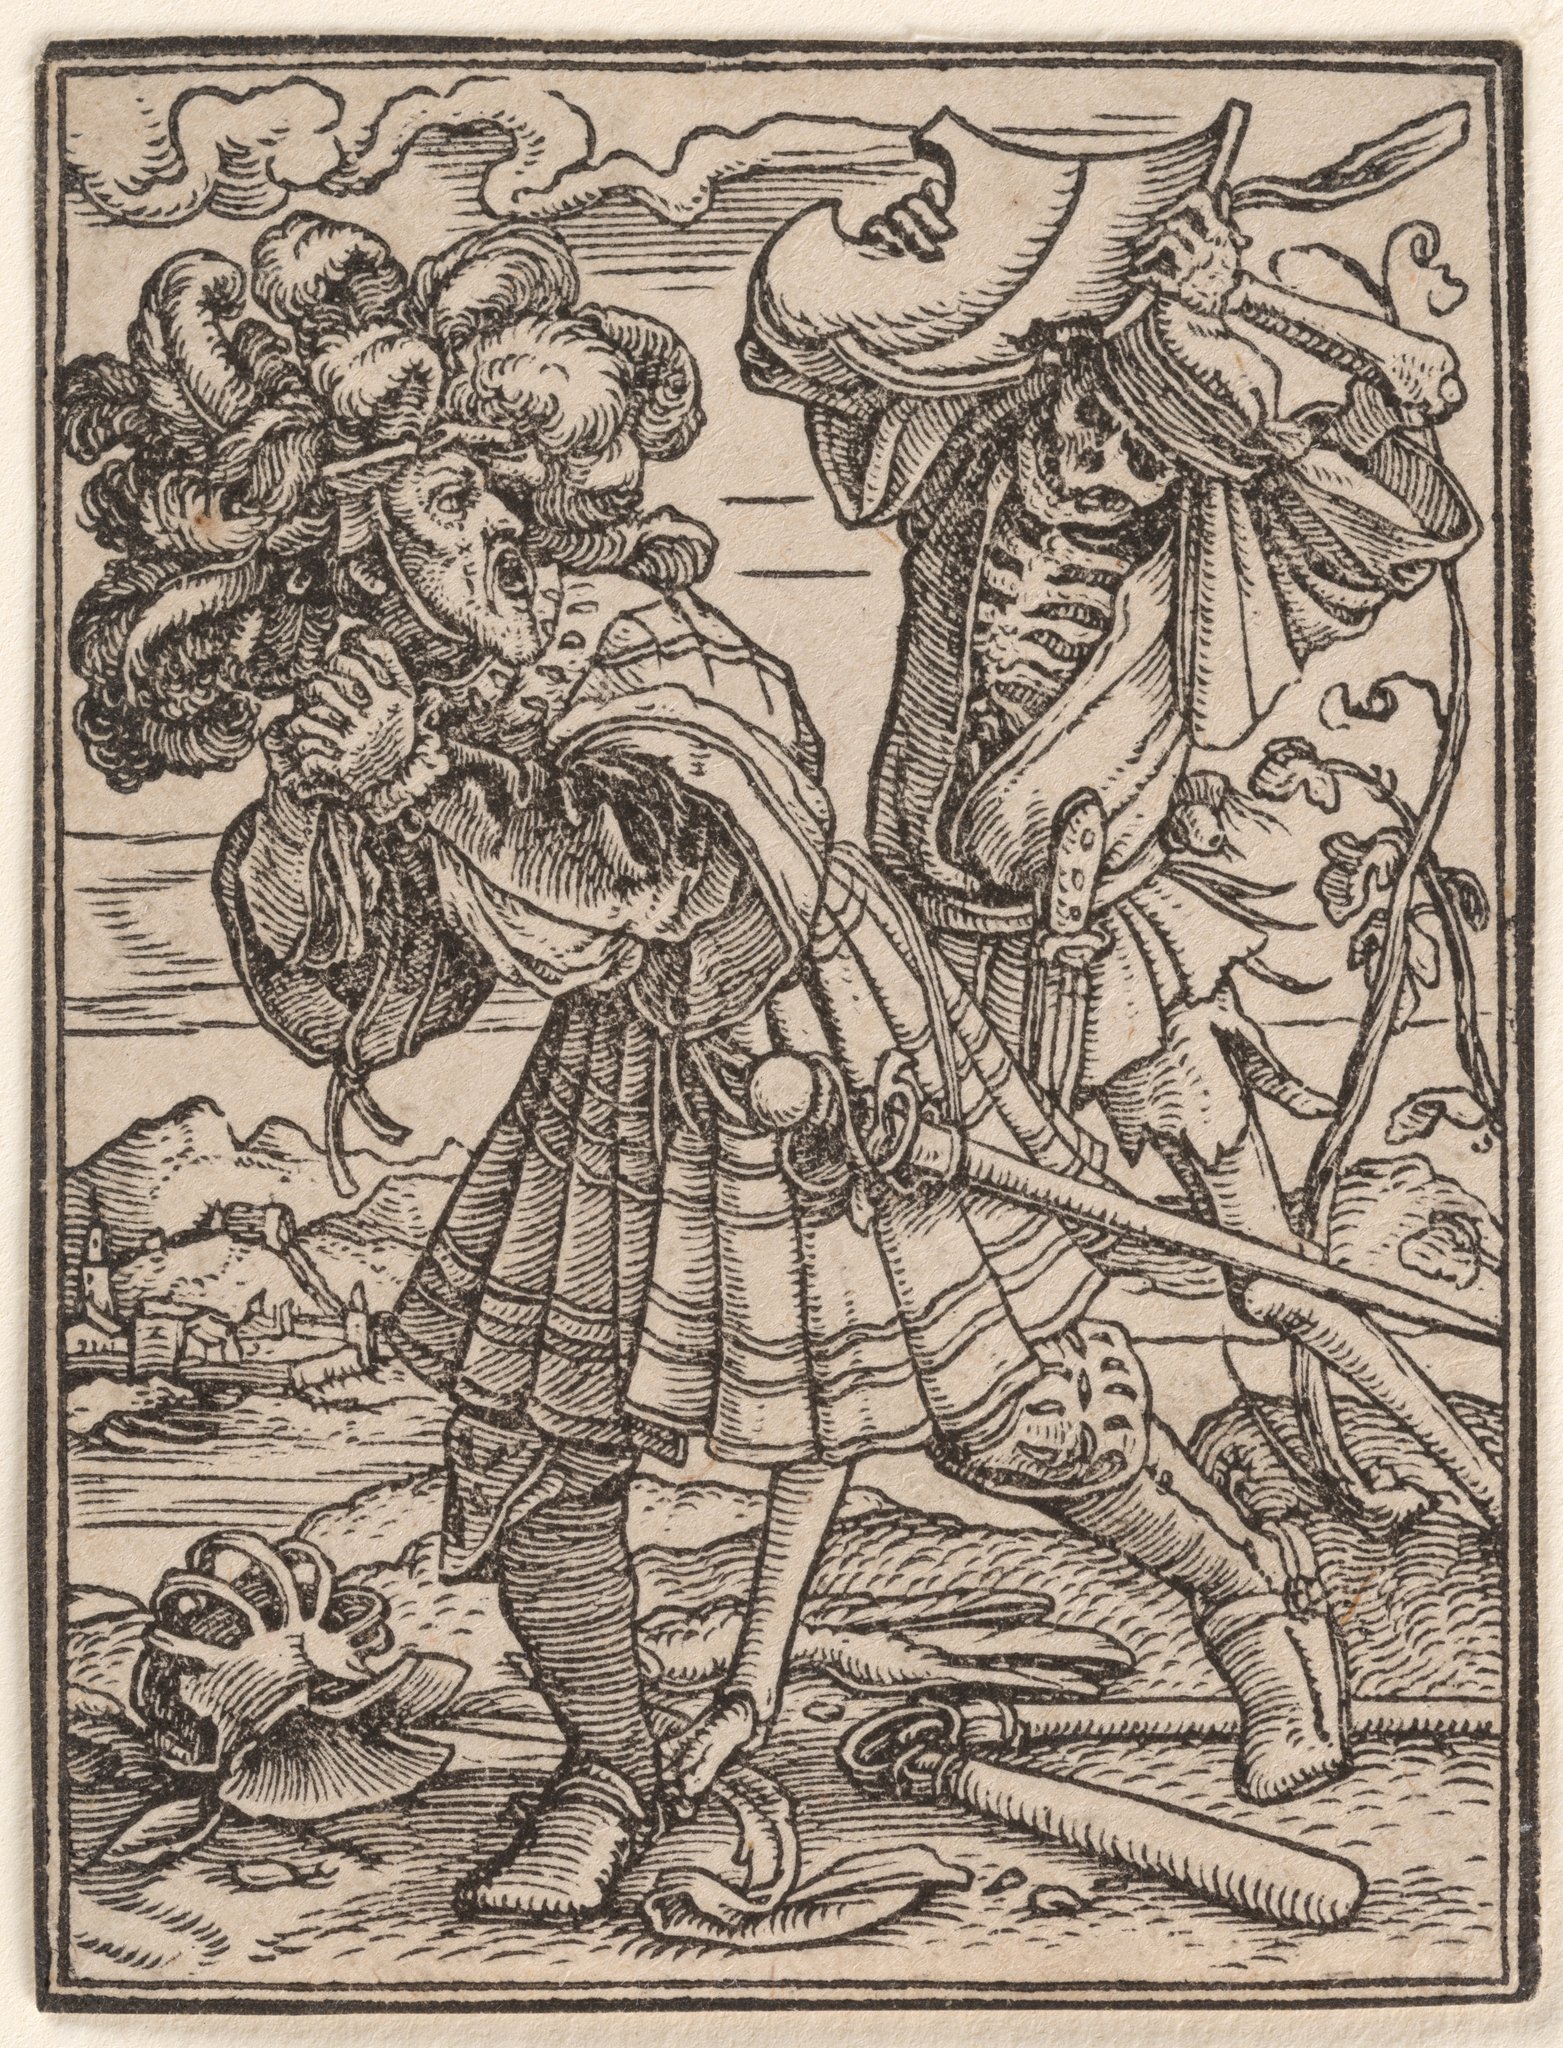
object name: print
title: The Count, from "The Dance of Death"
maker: hans holbein the younger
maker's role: artist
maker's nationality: german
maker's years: 1497-1543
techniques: woodcut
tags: skeletons,men